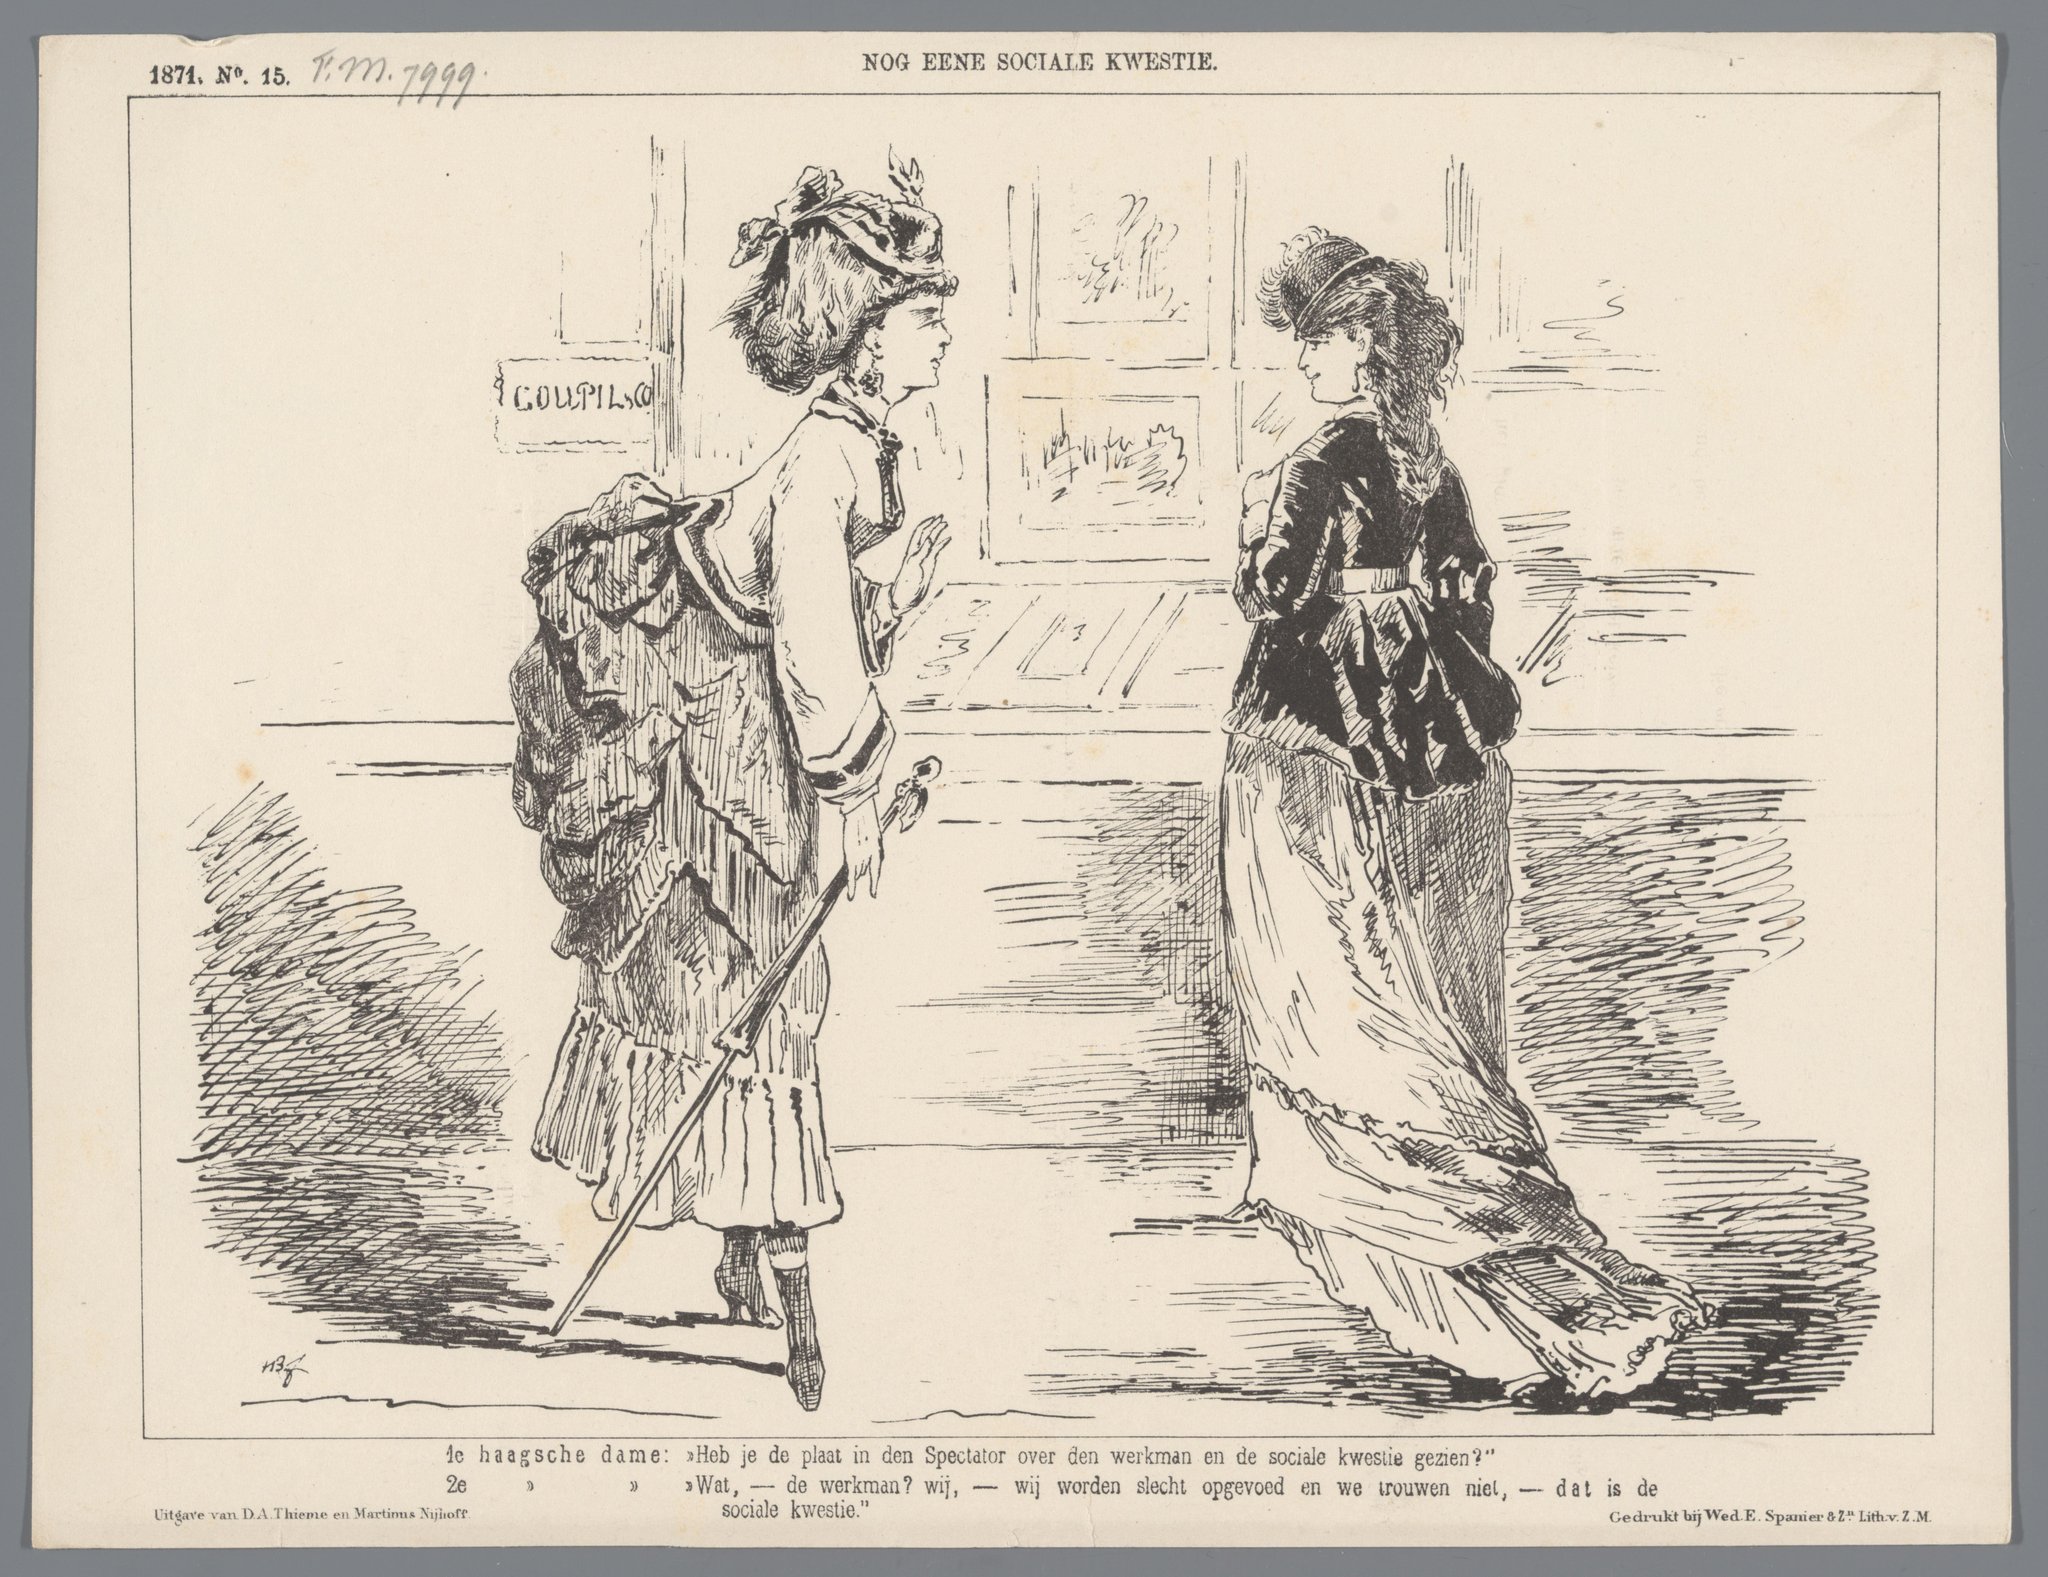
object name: cartoon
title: Nog eene sociale kwestie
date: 1871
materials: paper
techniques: lithograph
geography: arnhem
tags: printer, publisher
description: Spotprent met twee modiues gekleede Haagse dames die de zgn. sociale kwestie bespreken staande voor een etalage van Goupil & Co. Plaat verschenen bij het weekblad De Nederlandsche Spectator, nr. 15, 1871.